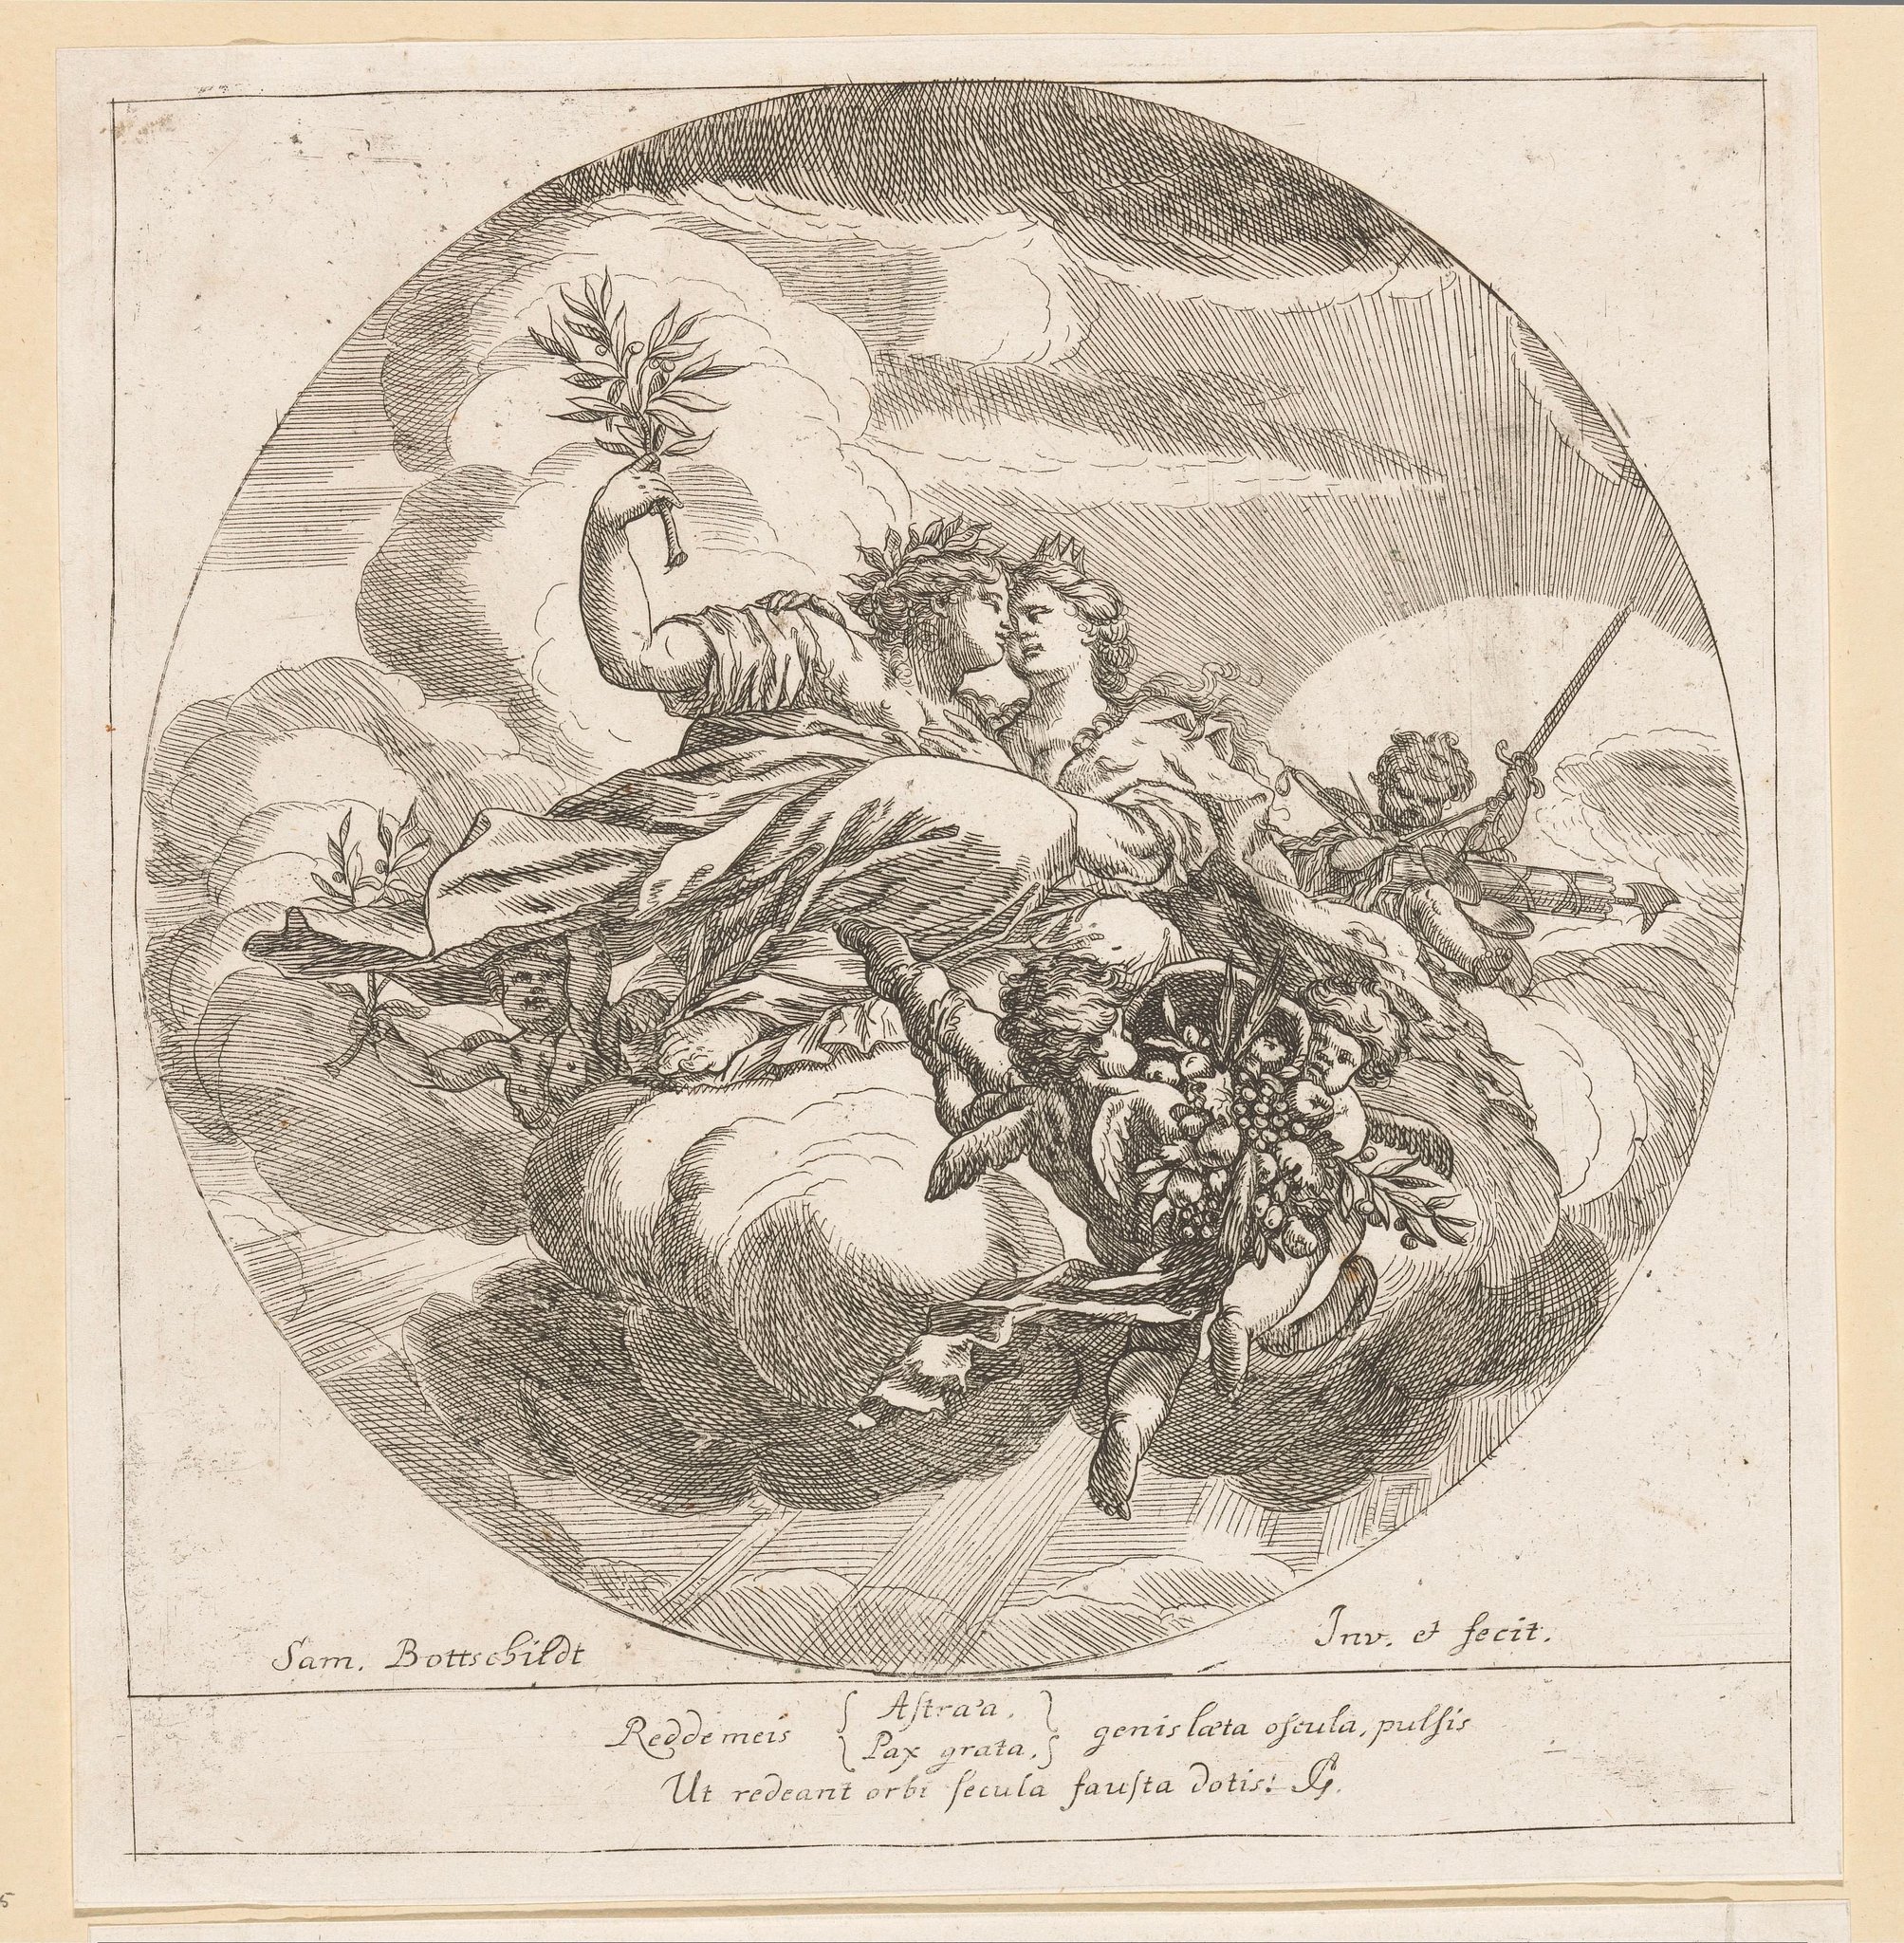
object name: print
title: Opera Varia Historica, Poetica & Iconologica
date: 1693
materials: paper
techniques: etching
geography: germany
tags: 'cornucopia', horn of plenty, (story of) dike (astraea), goddess of righteousness and justice, symbols, allegories of peace, 'pax'; 'pace' (ripa), sitting or standing on clouds, cupids: 'amores', 'amoretti', 'putti'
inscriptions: collector's mark: Lugt 240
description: Prent afkomstig uit de serie 'Opera Varia Historica, Poetica & Iconologica', uitgegeven in 1693. Deze serie omvat vrijwel het complete oeuvre van de kunstenaar en bestaat uit 48 prenten, voornamelijk ontwerpen voor plafonds.